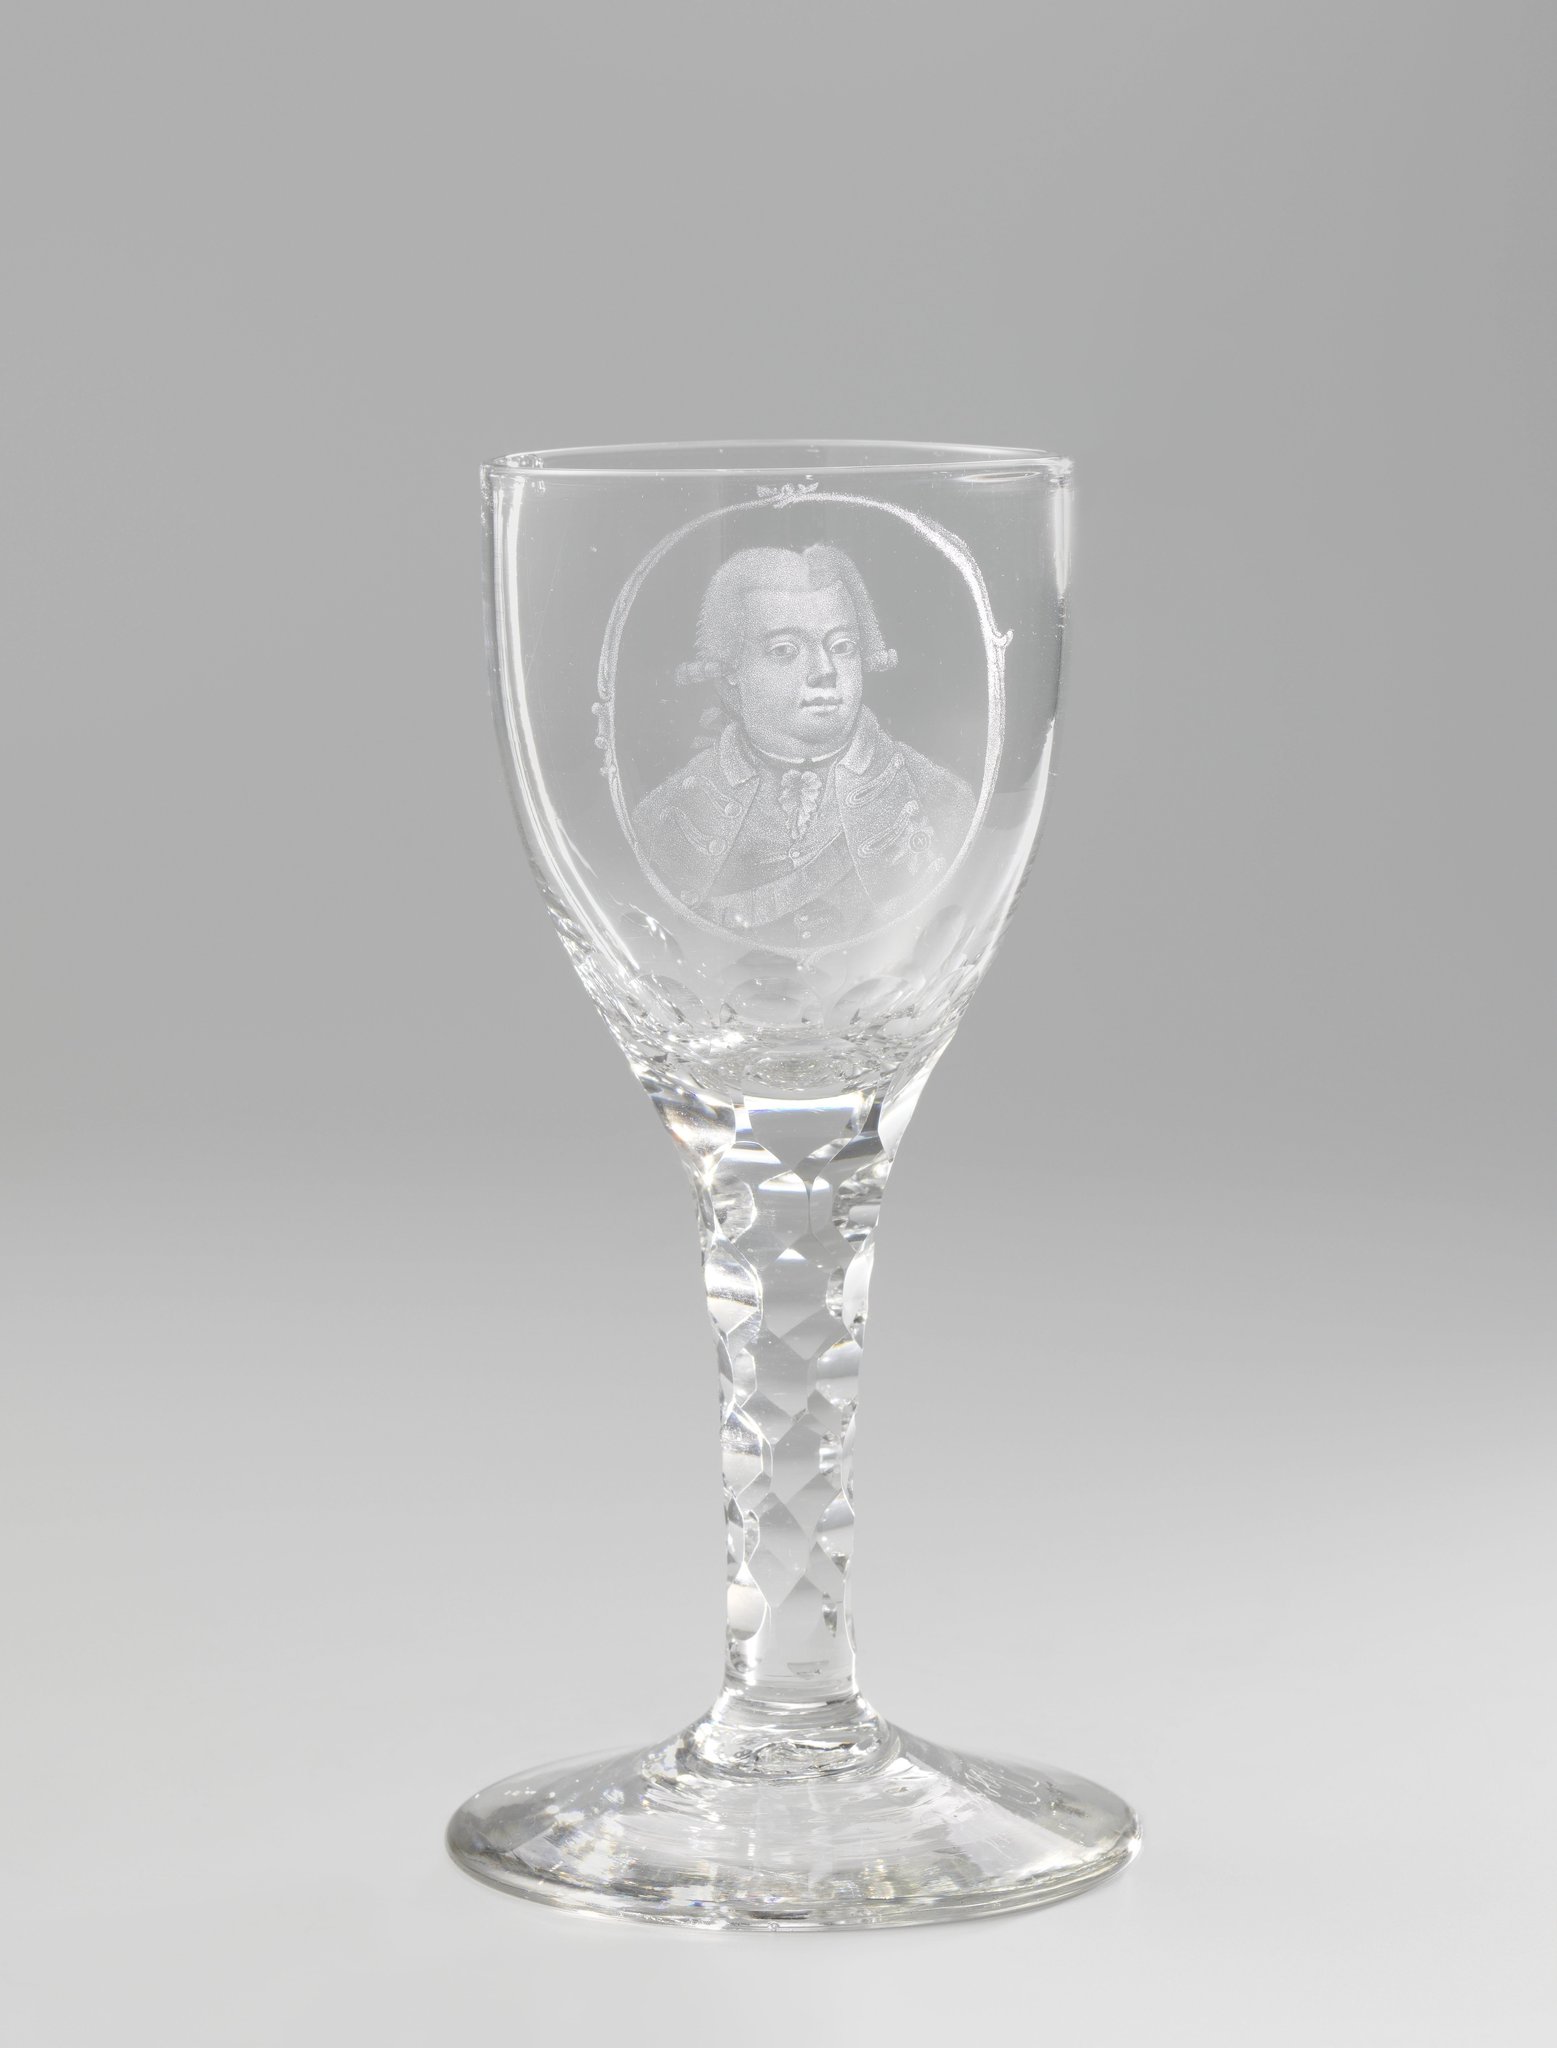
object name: goblet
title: Kelkglas met een portret van Willem V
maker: david wolff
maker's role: glasgraveur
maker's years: 1732-1798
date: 1796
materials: glass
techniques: glassblowing, grinding, engraving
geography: northern netherlands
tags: the hague, william v (prince of orange)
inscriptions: signature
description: Portrait of Stadholder William V, 1796. A.J. Enschedé bequest, 1896.